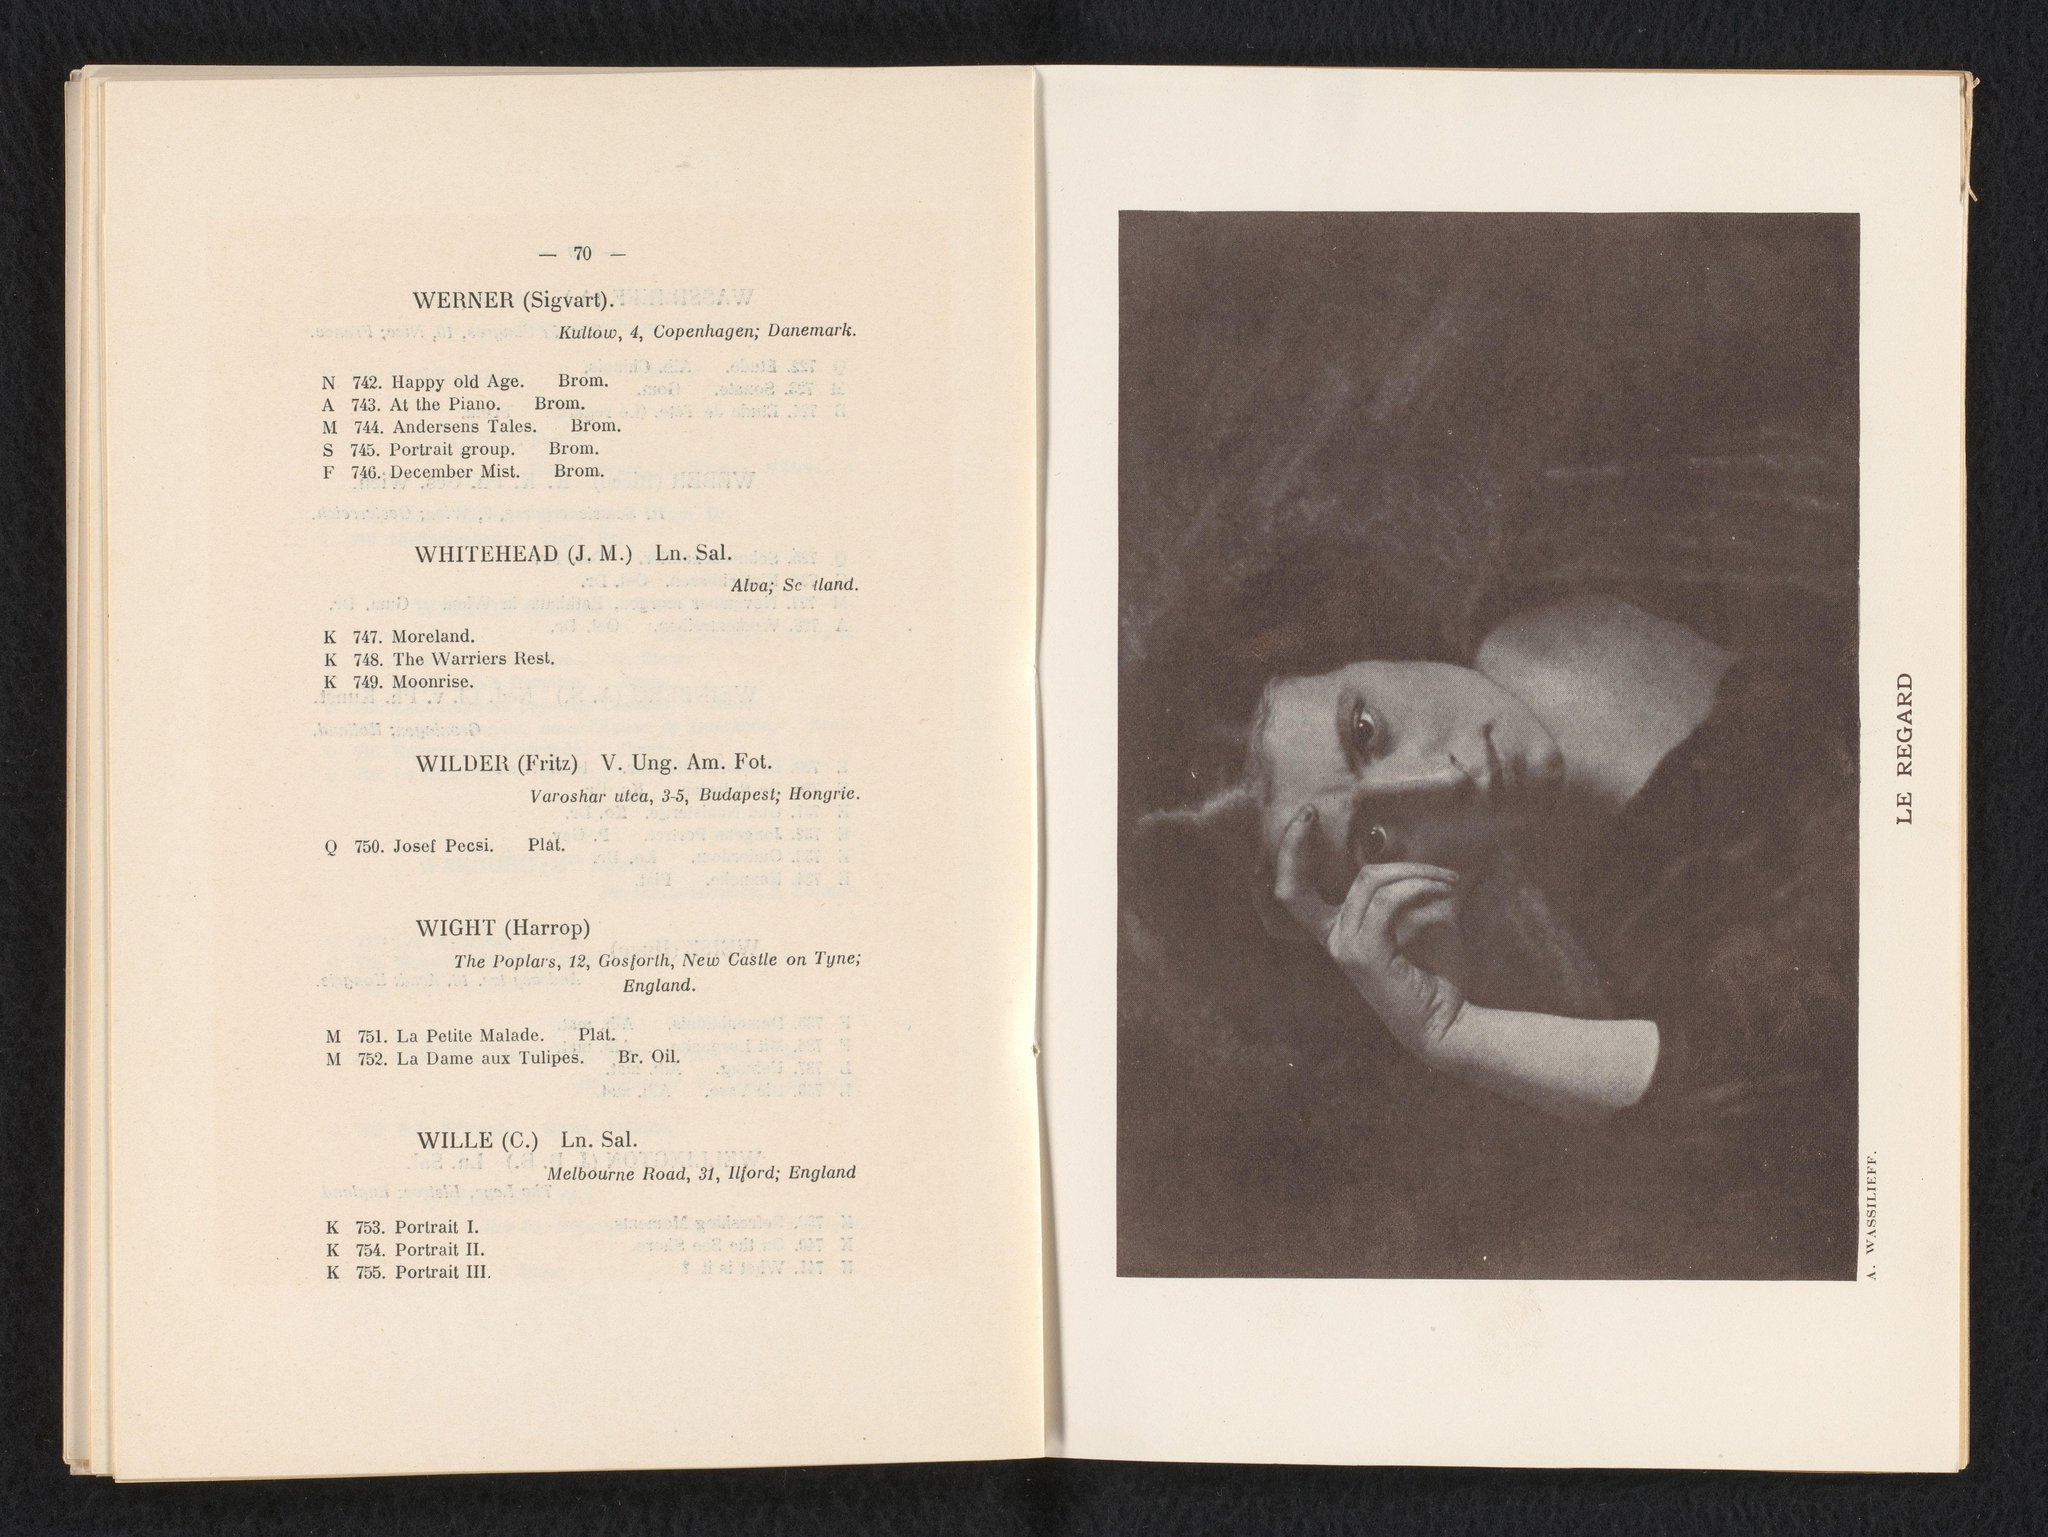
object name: photomechanical print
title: Le regard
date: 1908-1913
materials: paper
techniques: autotype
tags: historical persons not known by name - bb - woman